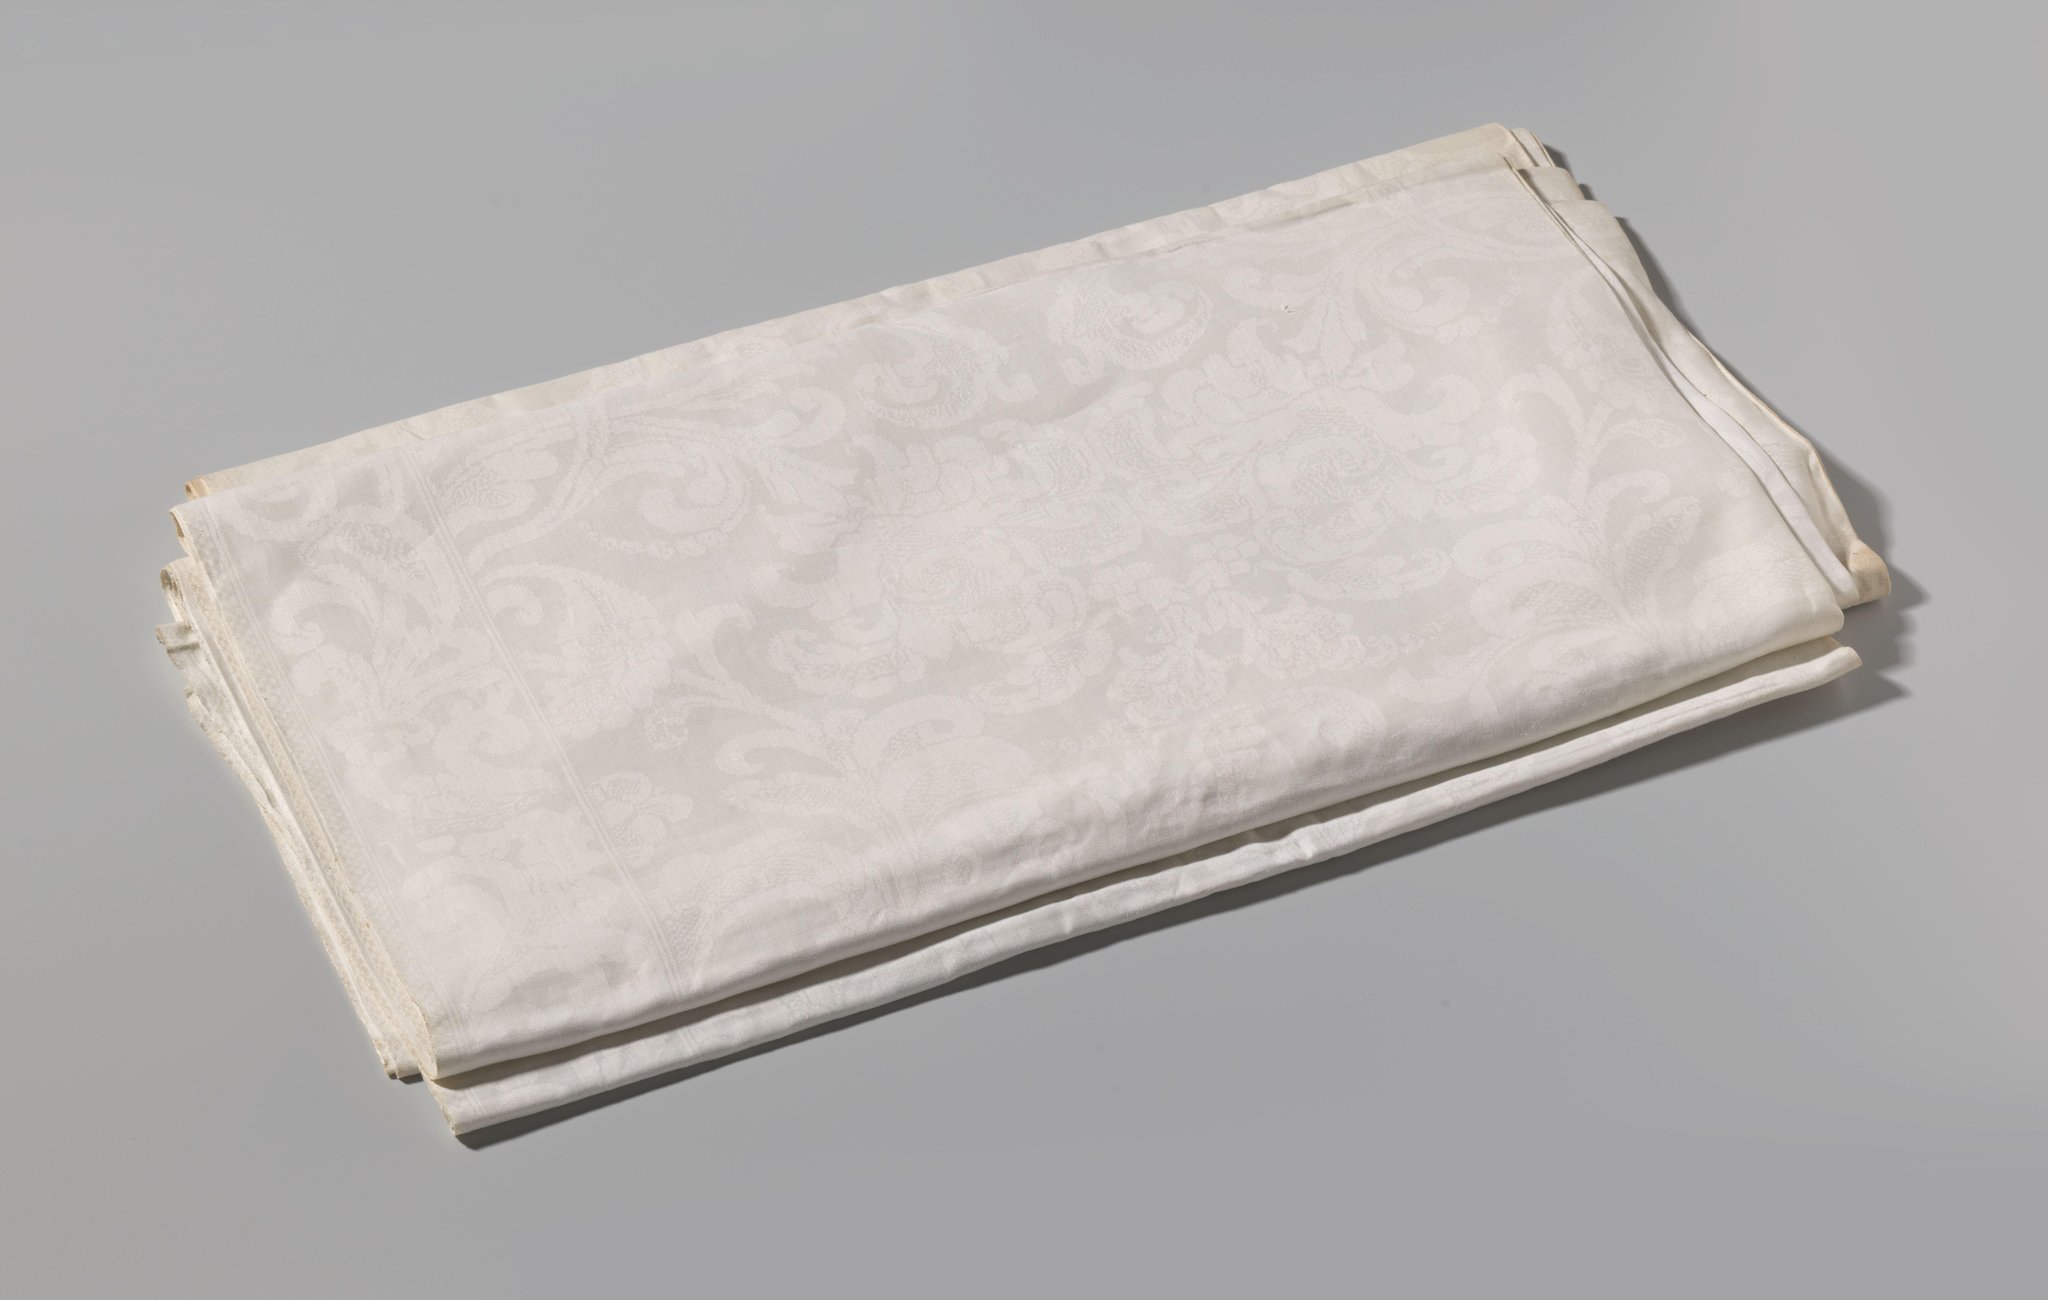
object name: tablecloth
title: Tafellaken van linnendamast met acanthusvoluten en wapens Van Bronckhorst en Van der Capellen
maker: Anonymous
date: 1680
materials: linen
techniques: damask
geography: netherlands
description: Tafellaken van linnendamast met patroon van acanthusvoluten en wapens Eustatius van Bronckhorst (1640-1697) en Margaretha van der Capellen (1641-1716), die in 1680 huwden. Horen twee servetten bij (BK-1976-113-A en B).